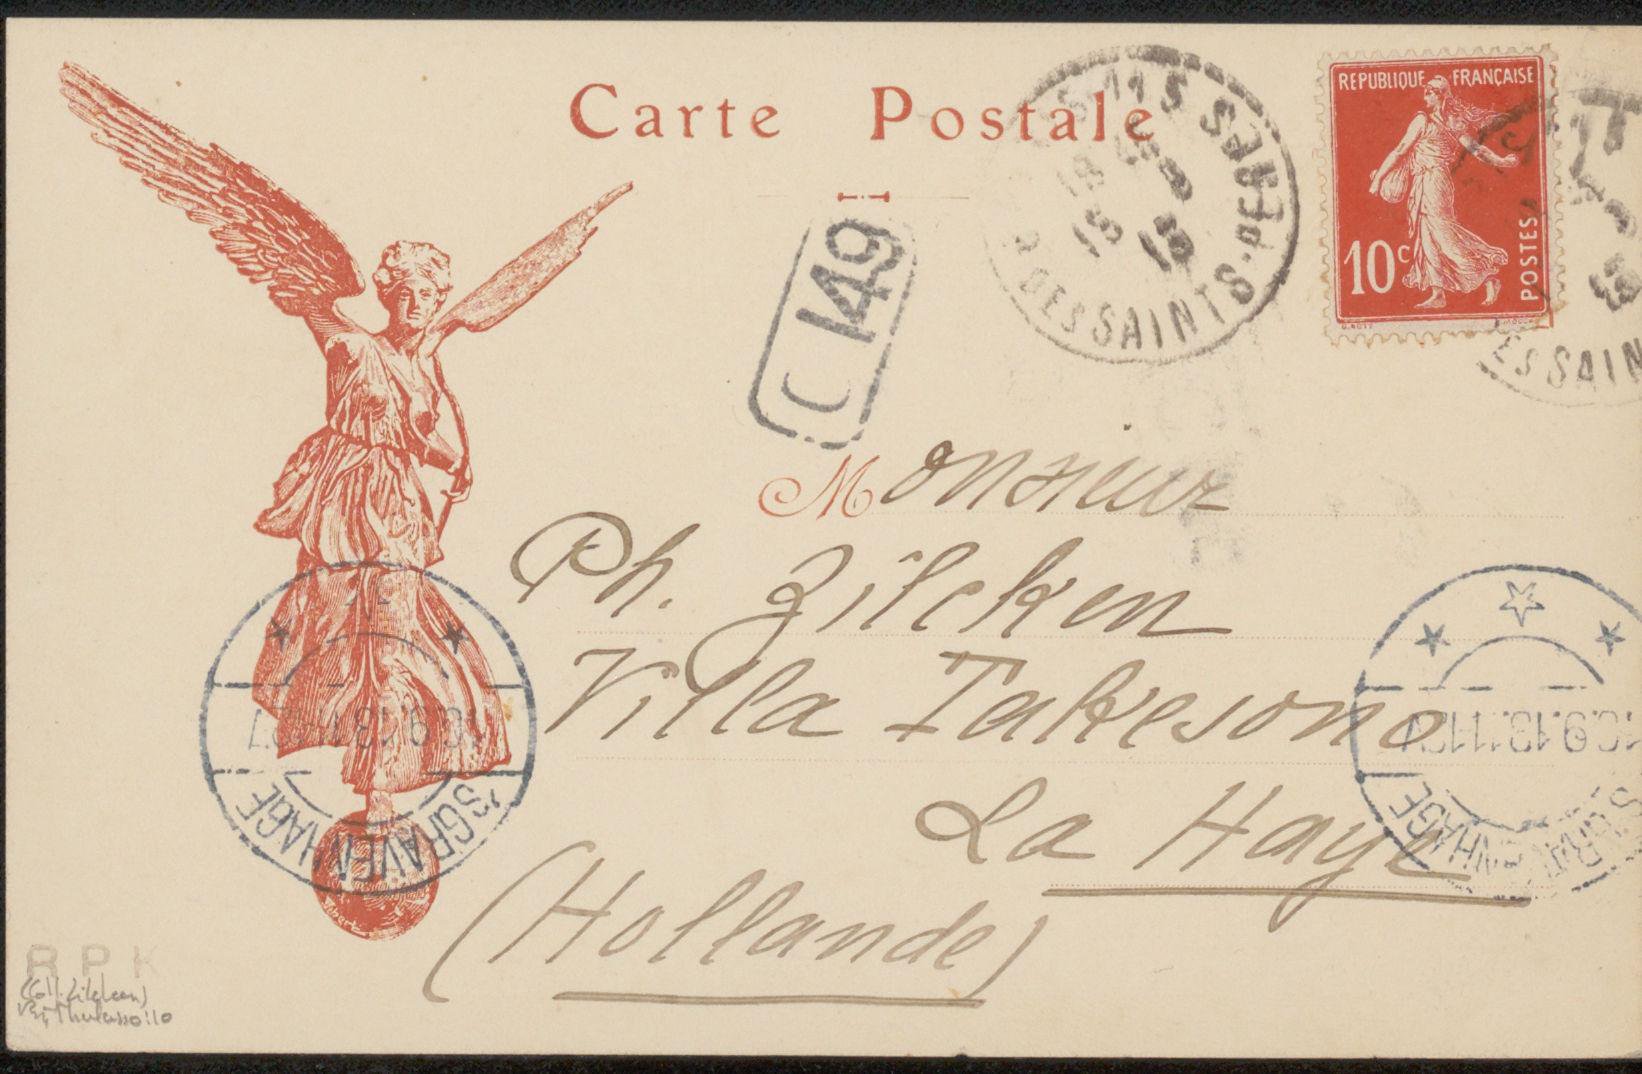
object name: postcard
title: Briefkaart aan Philip Zilcken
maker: adolphe thalasso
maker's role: criticus, dichter, dramaturg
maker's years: 1858-1919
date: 1913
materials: cardboard, ink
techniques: pen, printing, writing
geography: paris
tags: armand dayot, painter, draughtsman, philip zilcken, printed matter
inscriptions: collector's mark: ‘RPK’